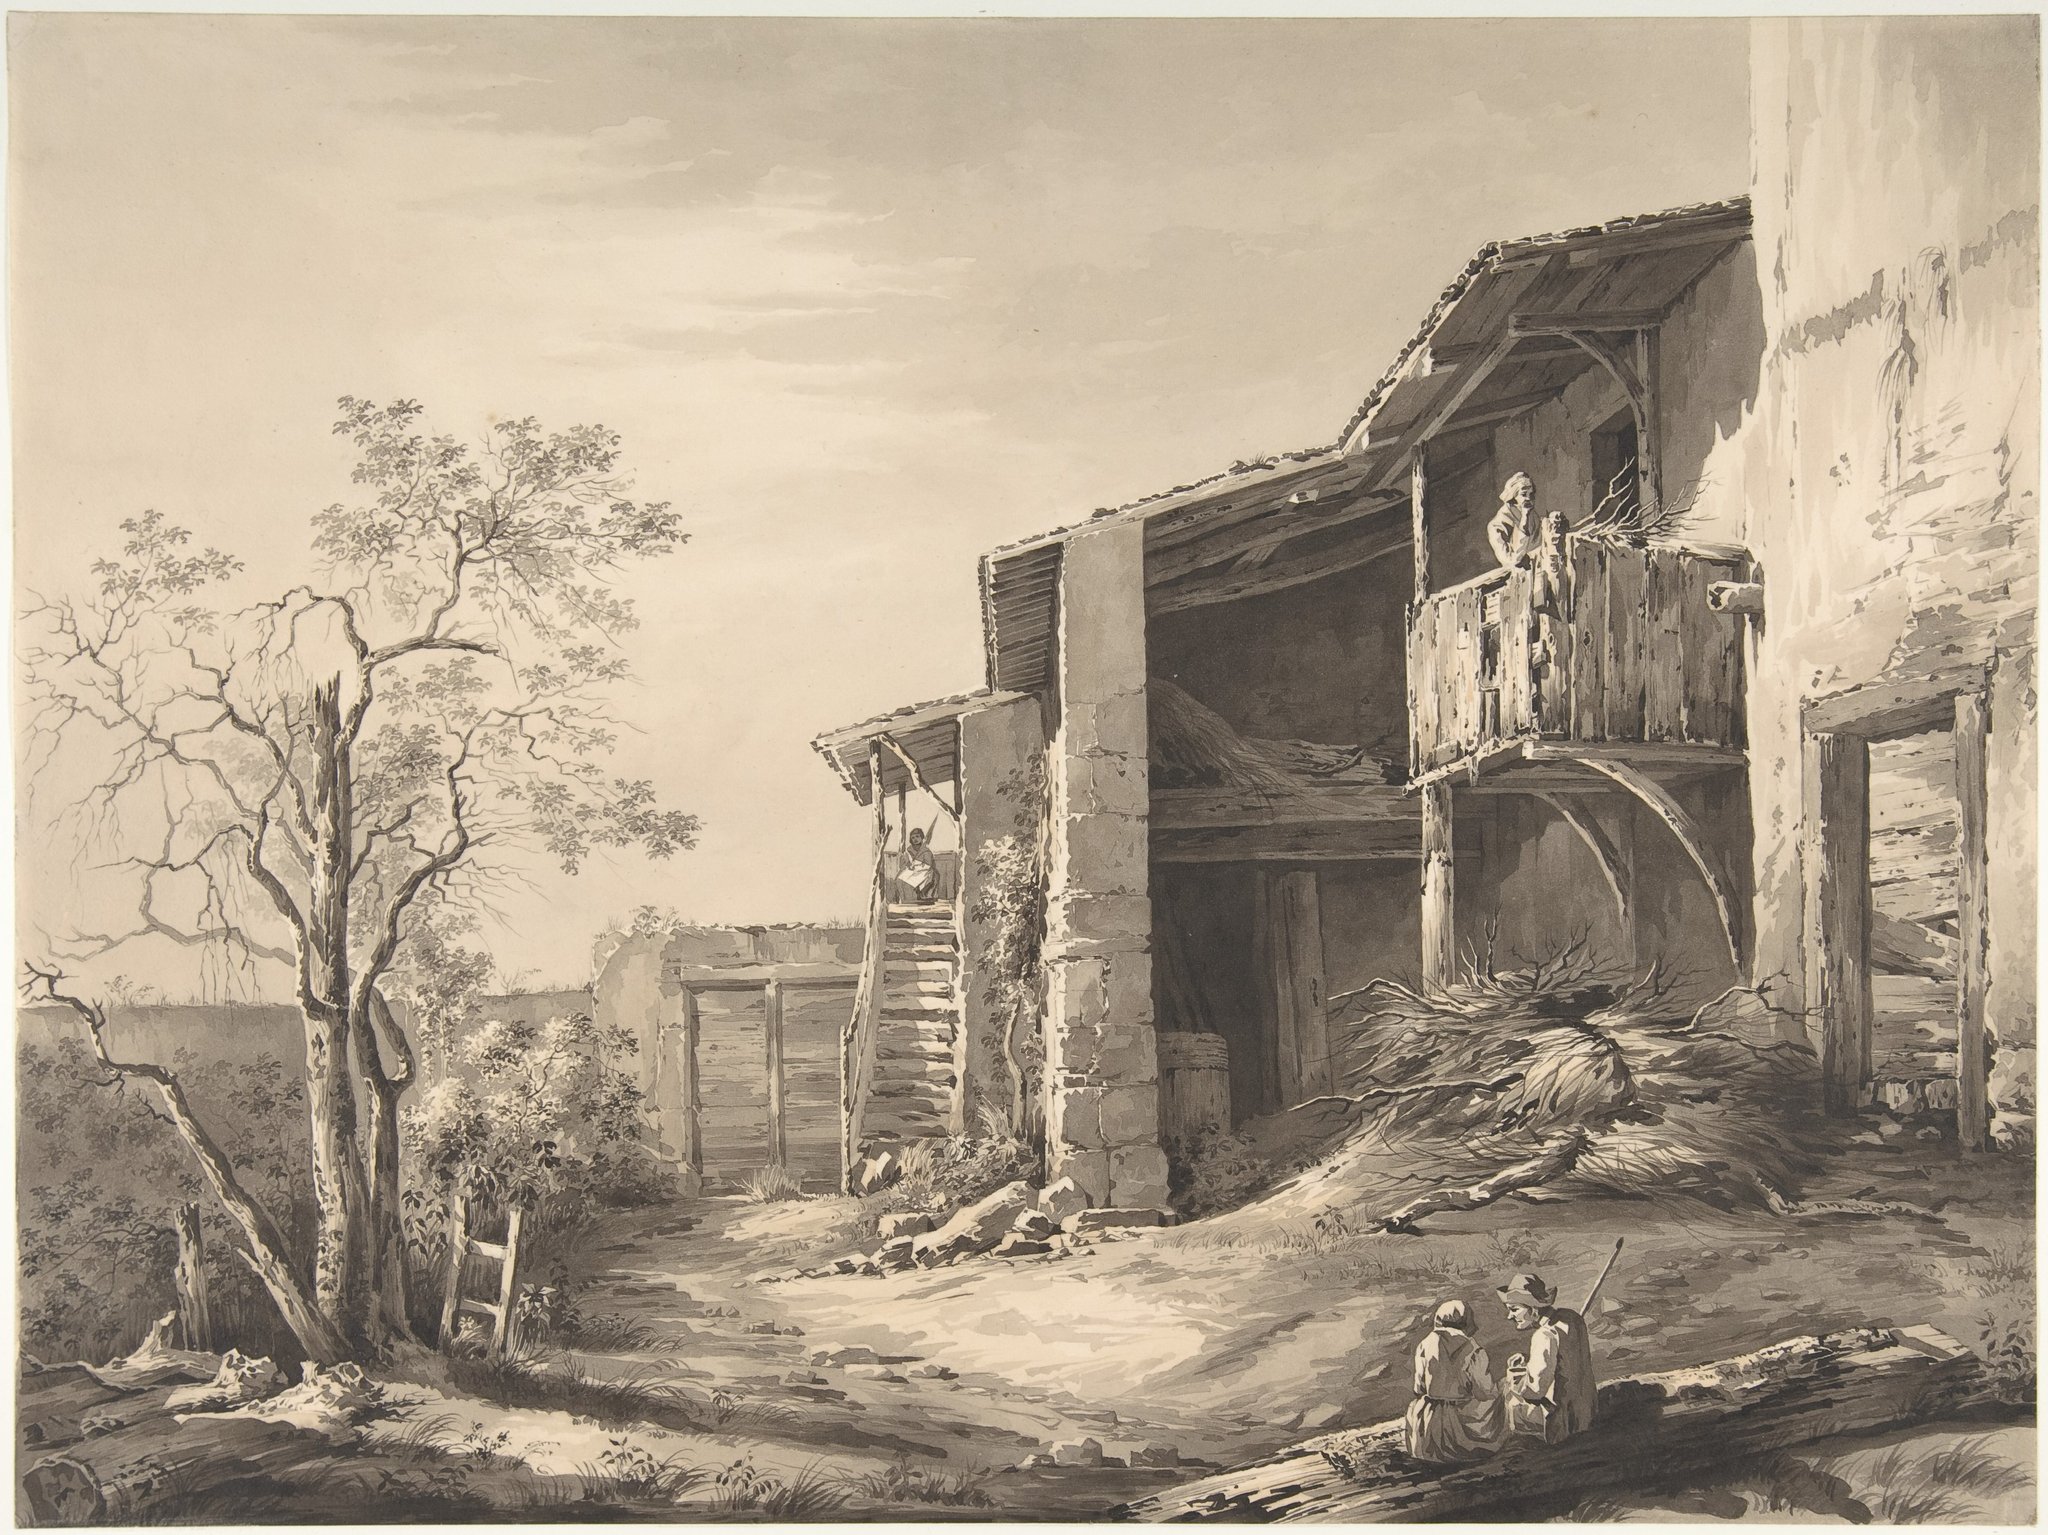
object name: drawing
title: Farmyard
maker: jean jacques de boissieu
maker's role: artist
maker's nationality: french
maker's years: 1736-1810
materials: chalk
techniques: brush, wash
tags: farms,men,trees